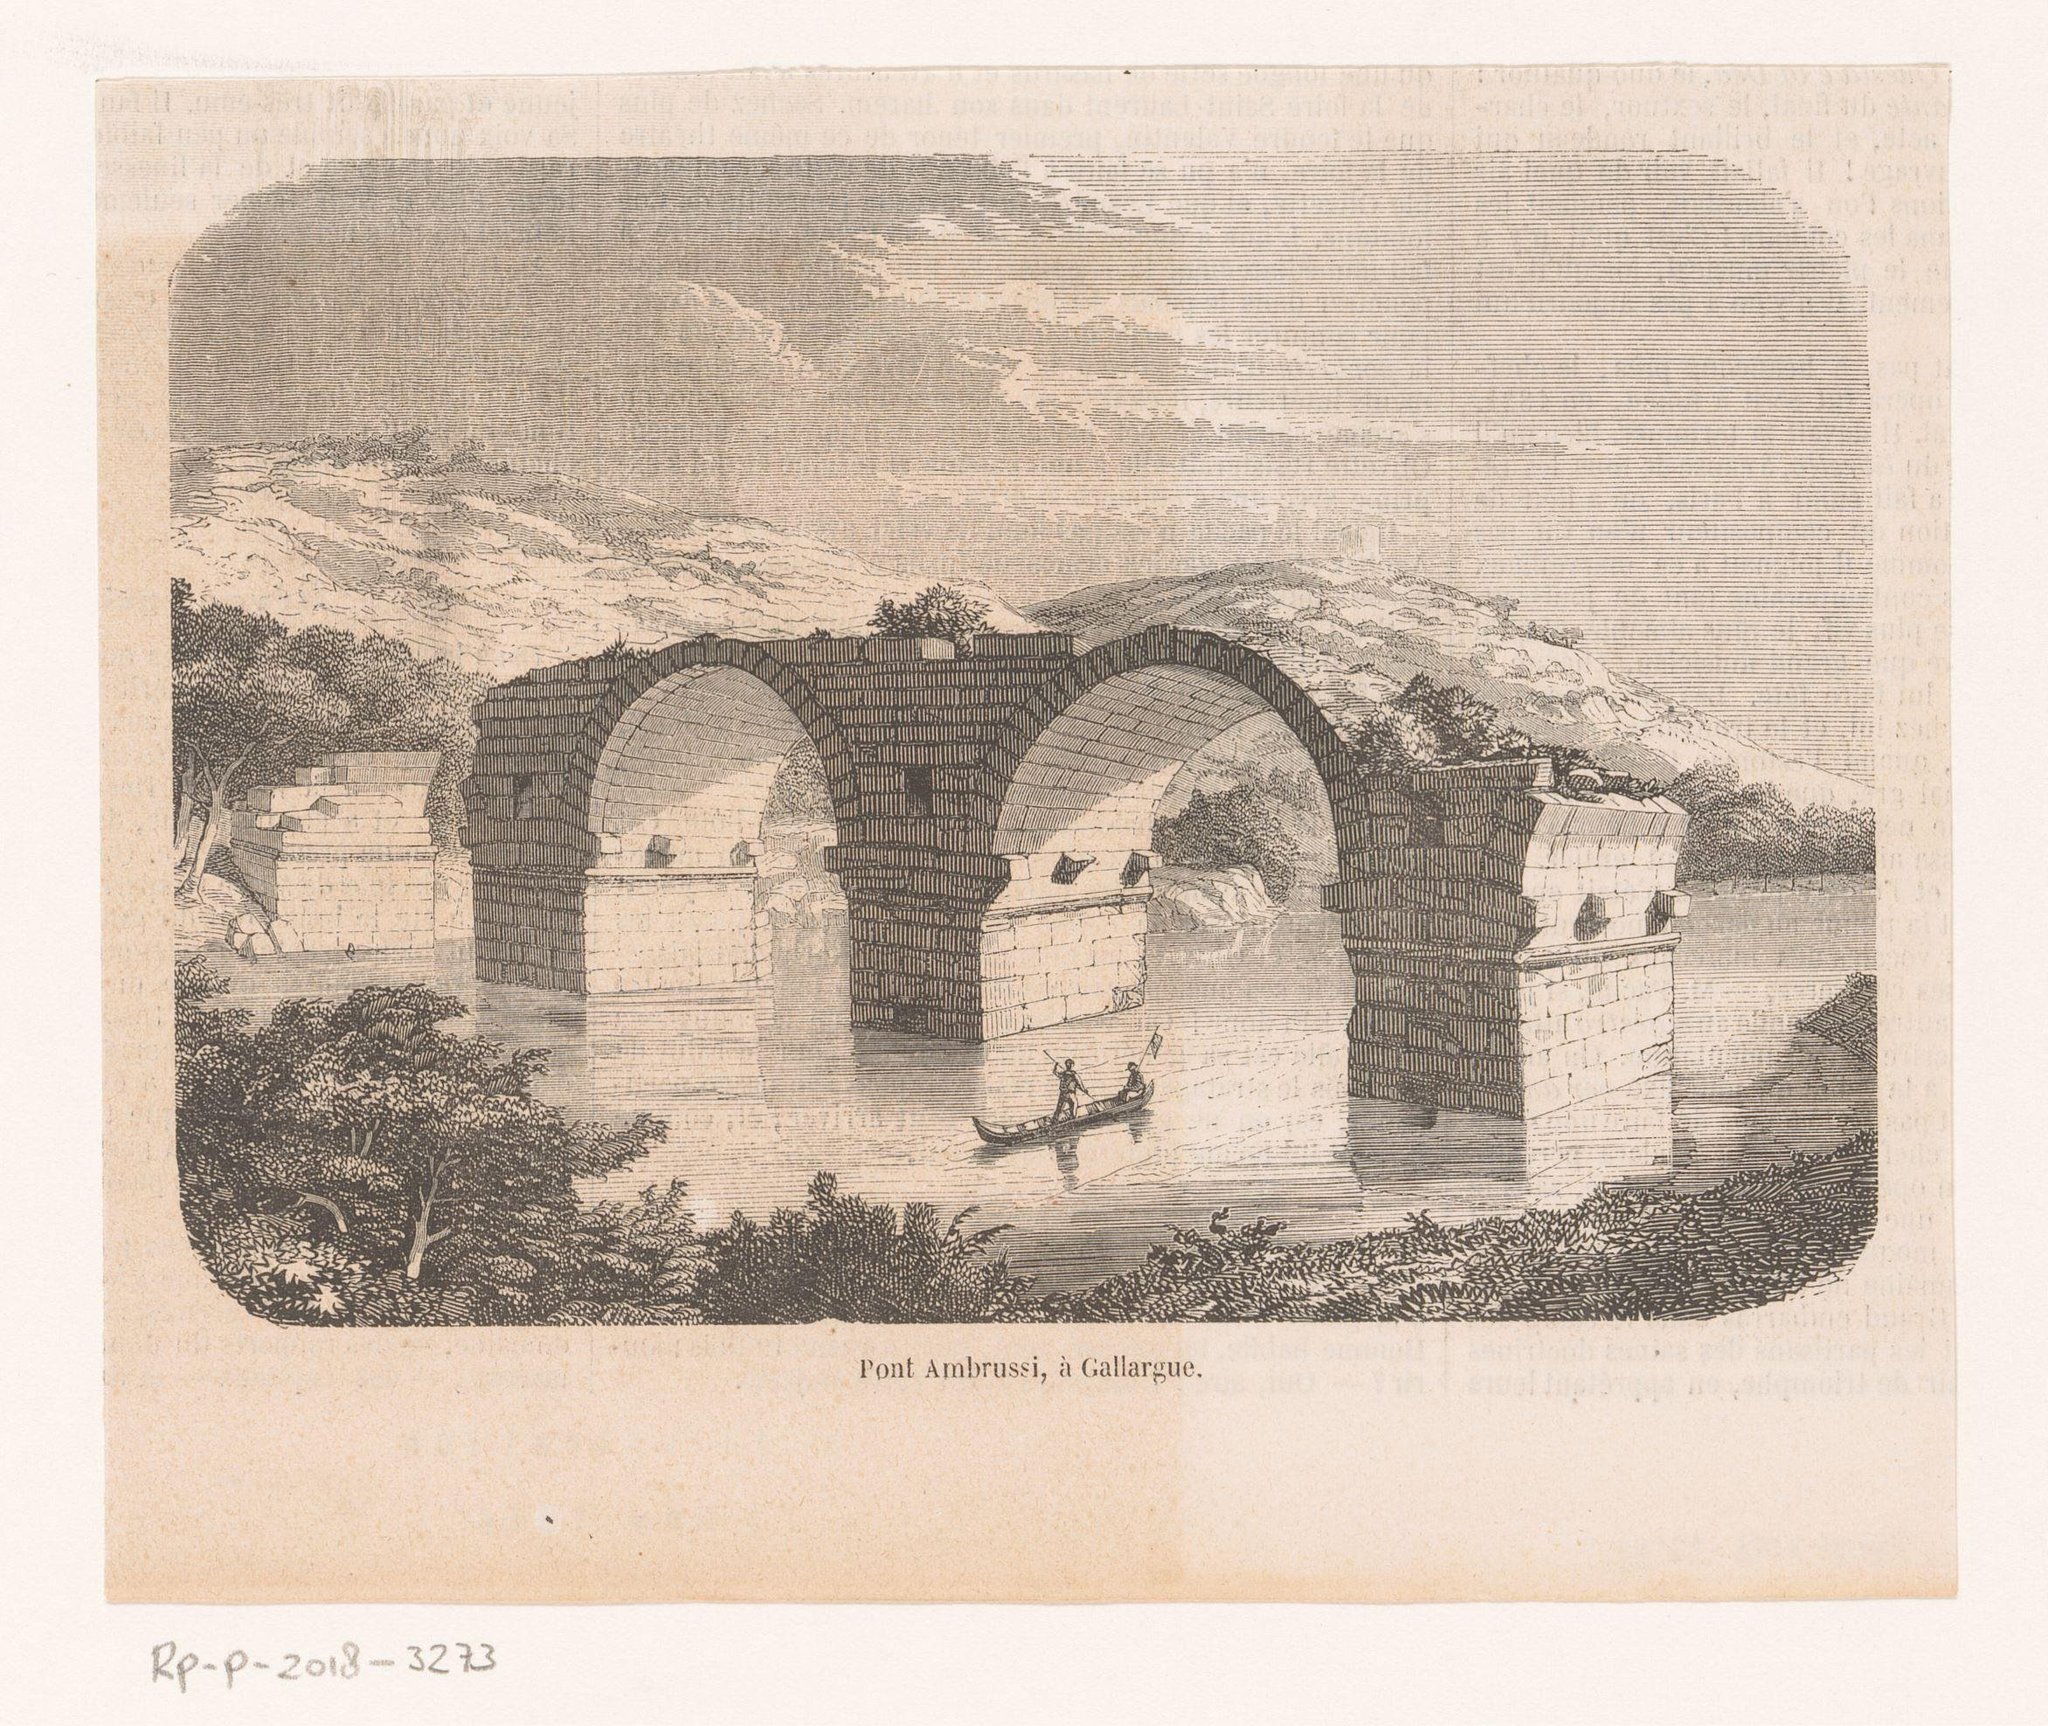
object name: print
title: Pont Ambrussi, à Gallargue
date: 1856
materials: paper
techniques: letterpress printing, engraving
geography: paris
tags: landscape with bridge, viaduct or aqueduct, france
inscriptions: inscription: ‘L'Illustration 11 Nov. 1854’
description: Gezicht op de Romeinse brug Pont Ambroix (Ambrussum) gelegen bij Gallargues-le-Montueux.